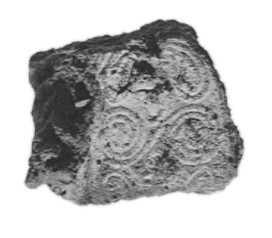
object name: sealing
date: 2030-1640 BCE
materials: clay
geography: egypt